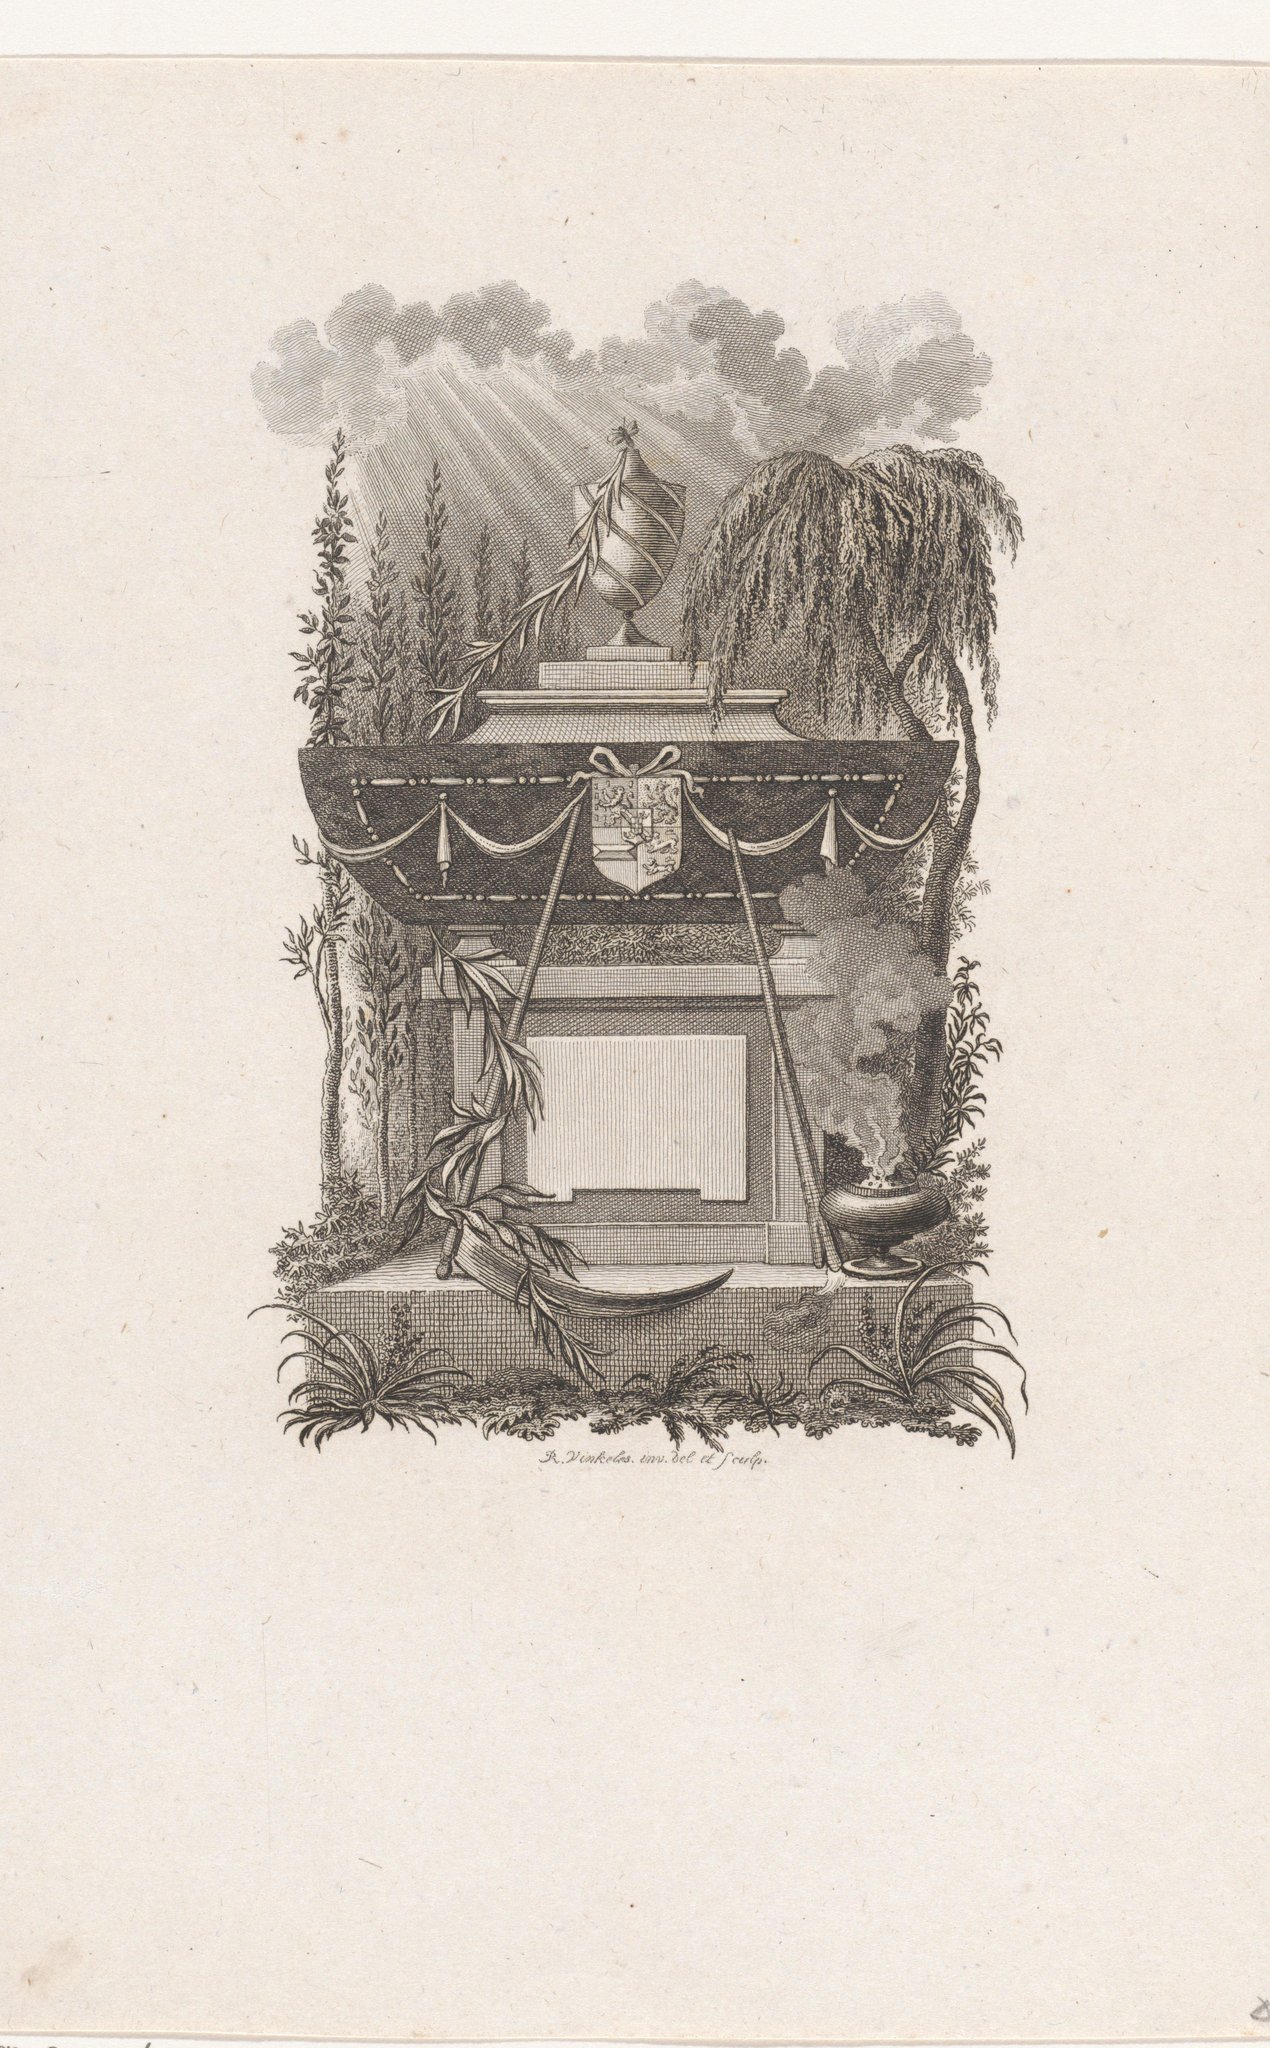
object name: print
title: Grafmonument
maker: reinier vinkeles (i)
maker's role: draughtsman, print maker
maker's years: 1741-1816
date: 1751-1816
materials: paper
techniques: engraving, etching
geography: amsterdam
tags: agricultural implements: scythe, father time, man with wings and scythe (+ variant), grave-building, monumental tomb, smoking pot as symbol of 'vanitas'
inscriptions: collector's mark: Lugt 240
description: Grafmonument met een oningevuld cartouche, een rokende pot en een zeis.